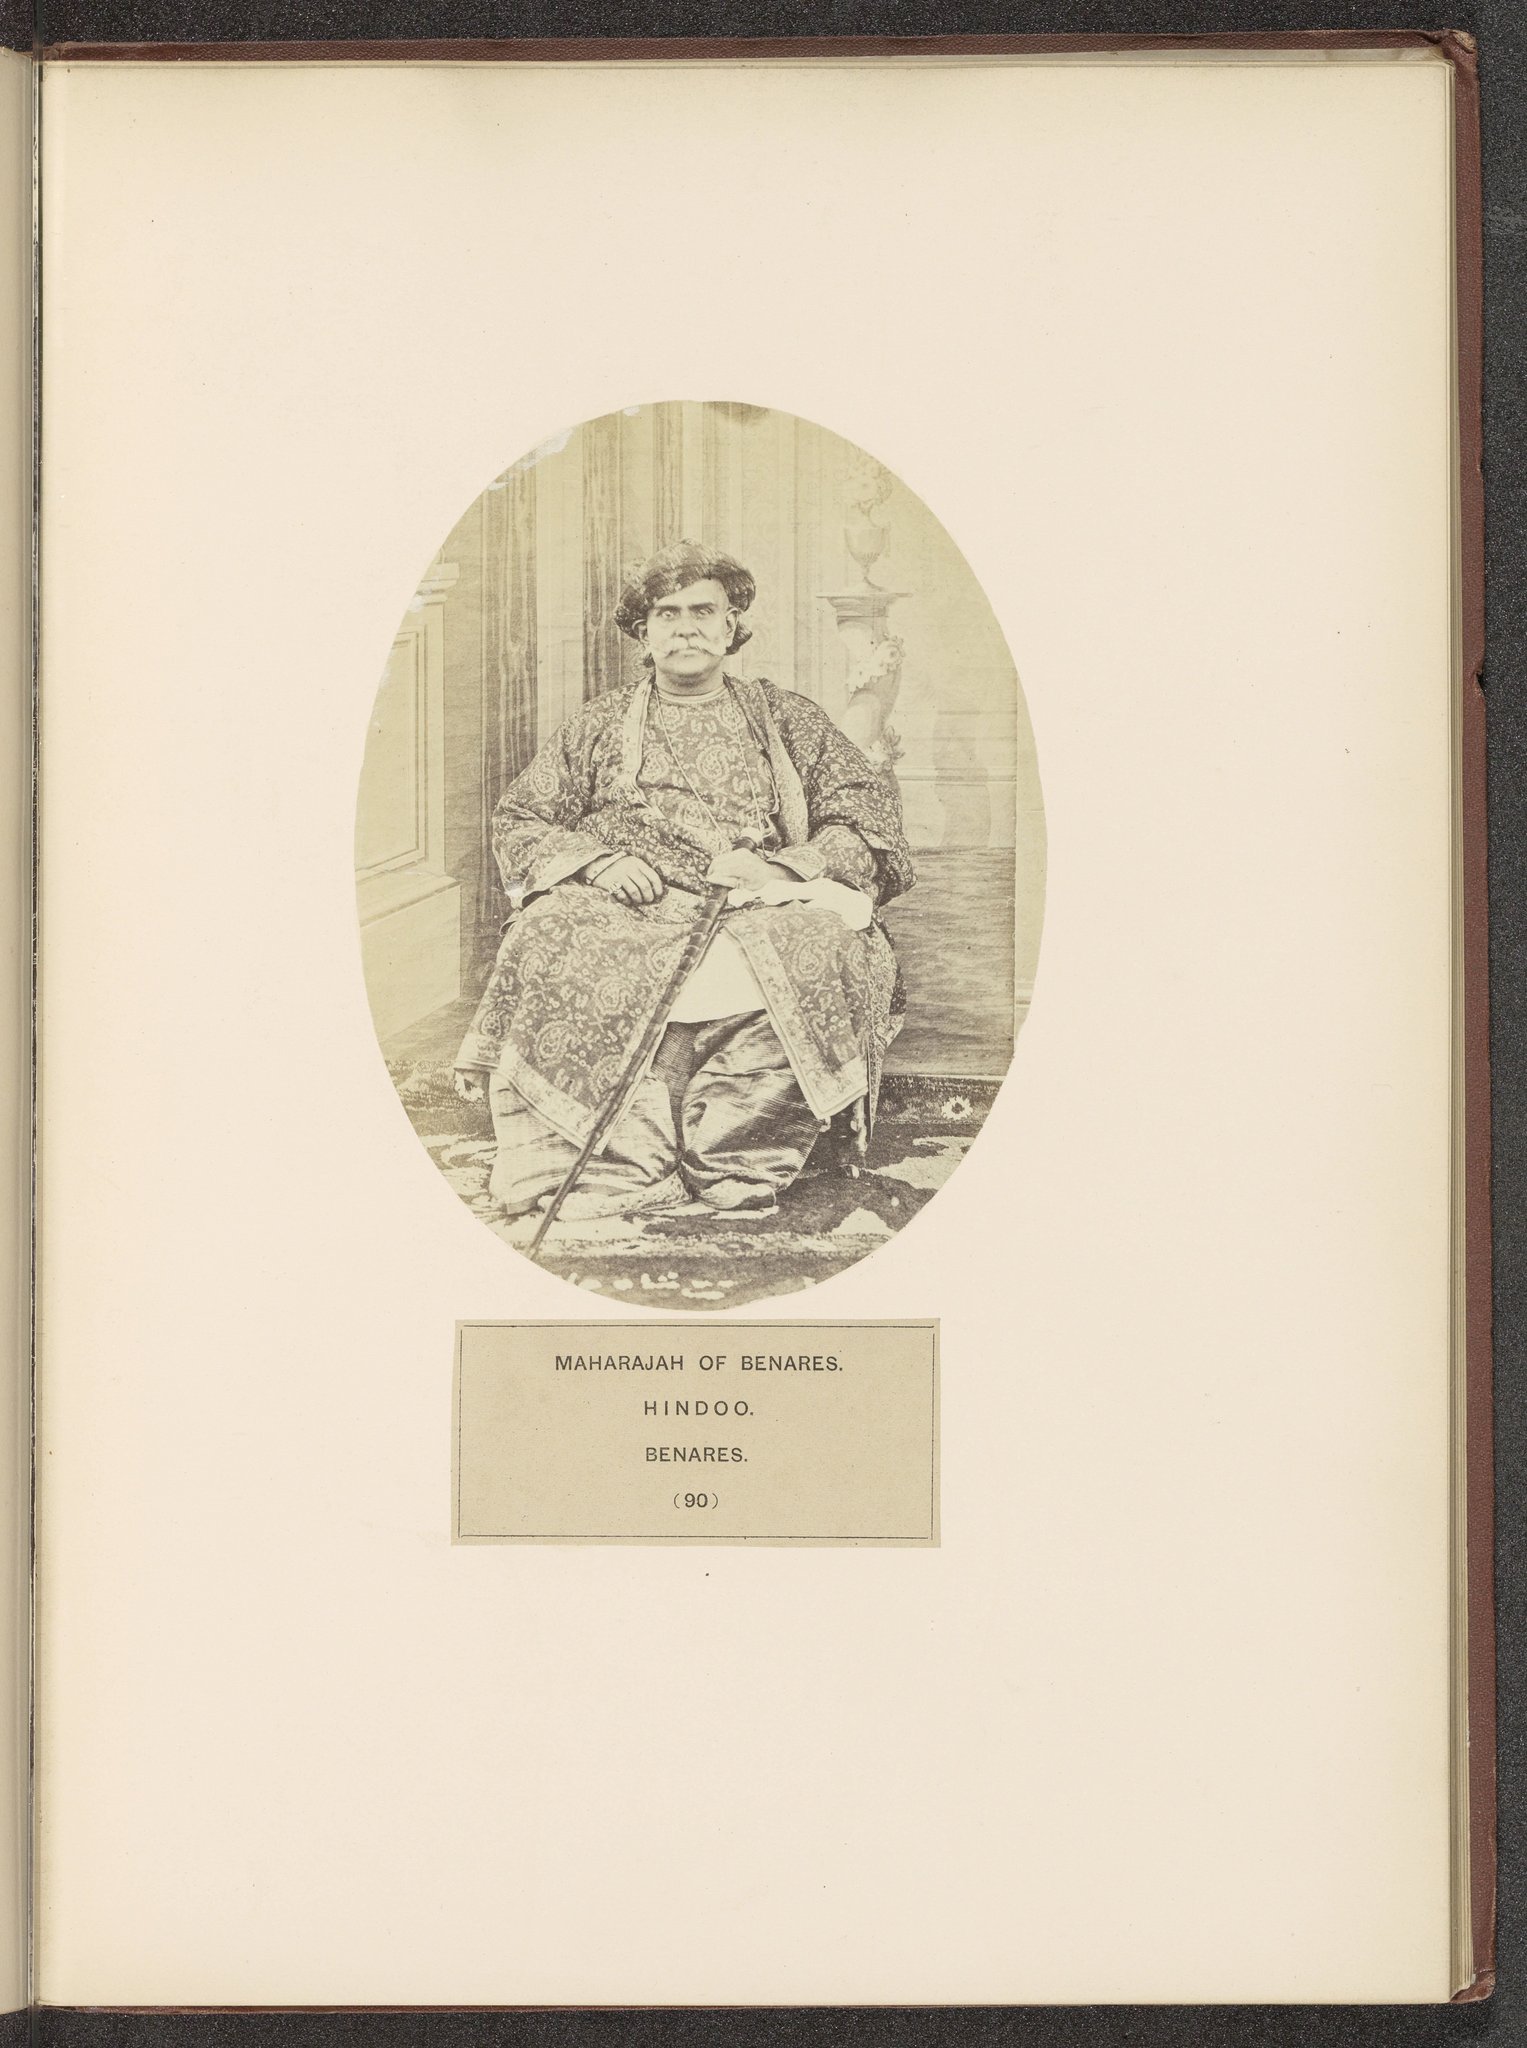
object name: page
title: Portrait of the Maharaja of Varanasi, Uttar Pradesh, India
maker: Anonymous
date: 1858-1868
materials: photographic support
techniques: albumen print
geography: varanasi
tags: ruler, sovereign, human races; peoples; nationalities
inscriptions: inscription: ‘MAHARAJAH OF BENARES./ HINDOO./ BENARES.’, number: ‘(90)’